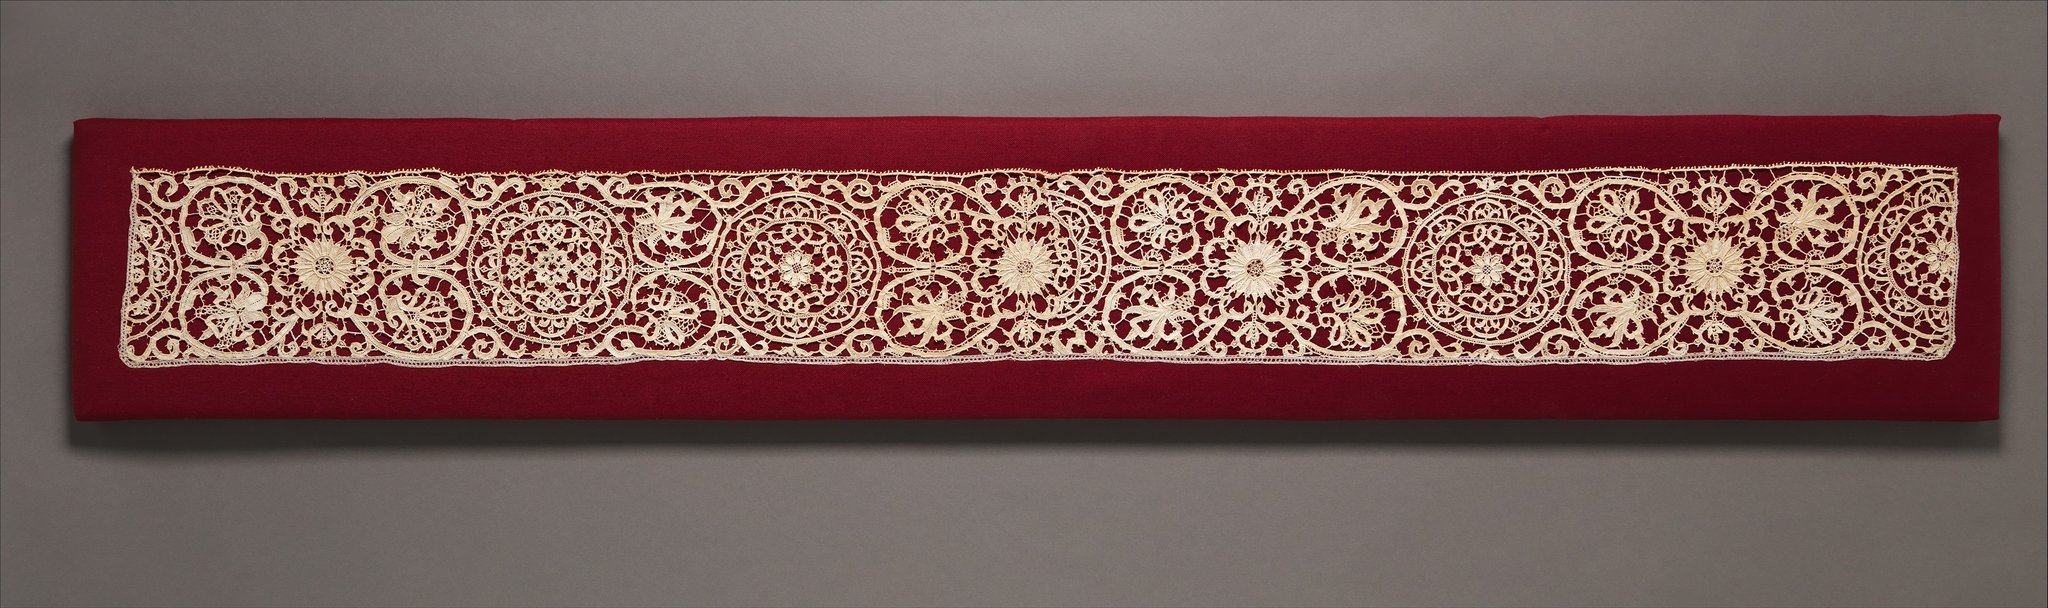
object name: border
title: Border of needle lace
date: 1601-1633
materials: linen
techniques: lace